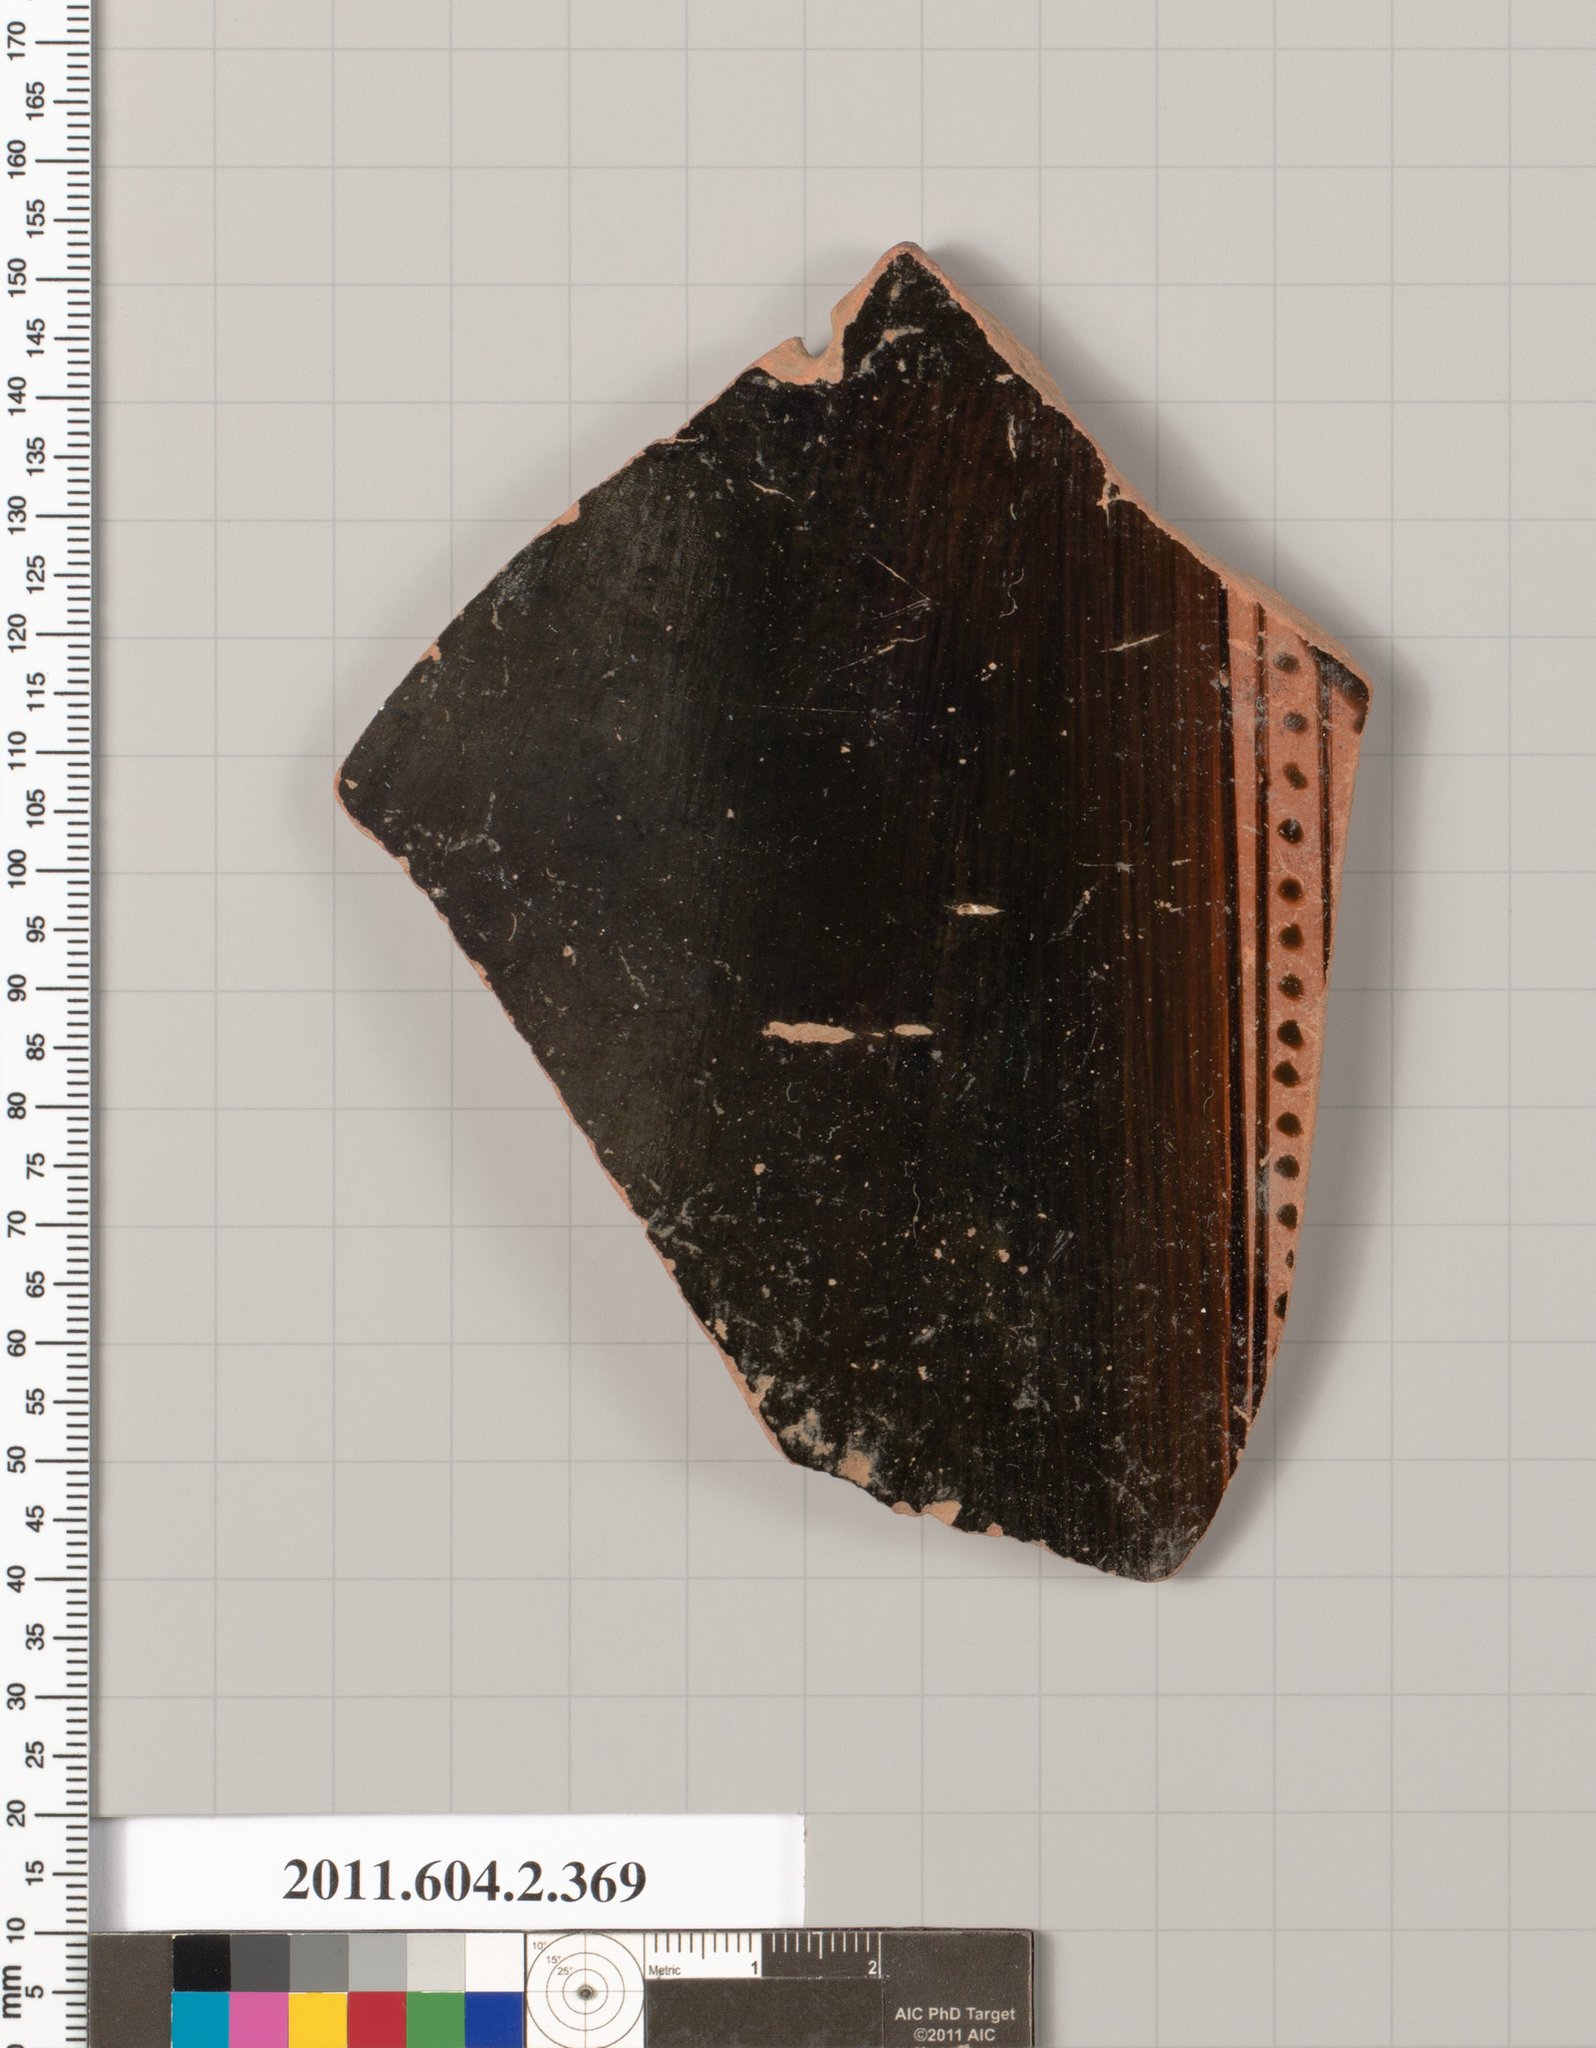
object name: column krater fragment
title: Terracotta fragment of a pelike? (jar)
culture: greek, attic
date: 450-430 BCE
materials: terracotta